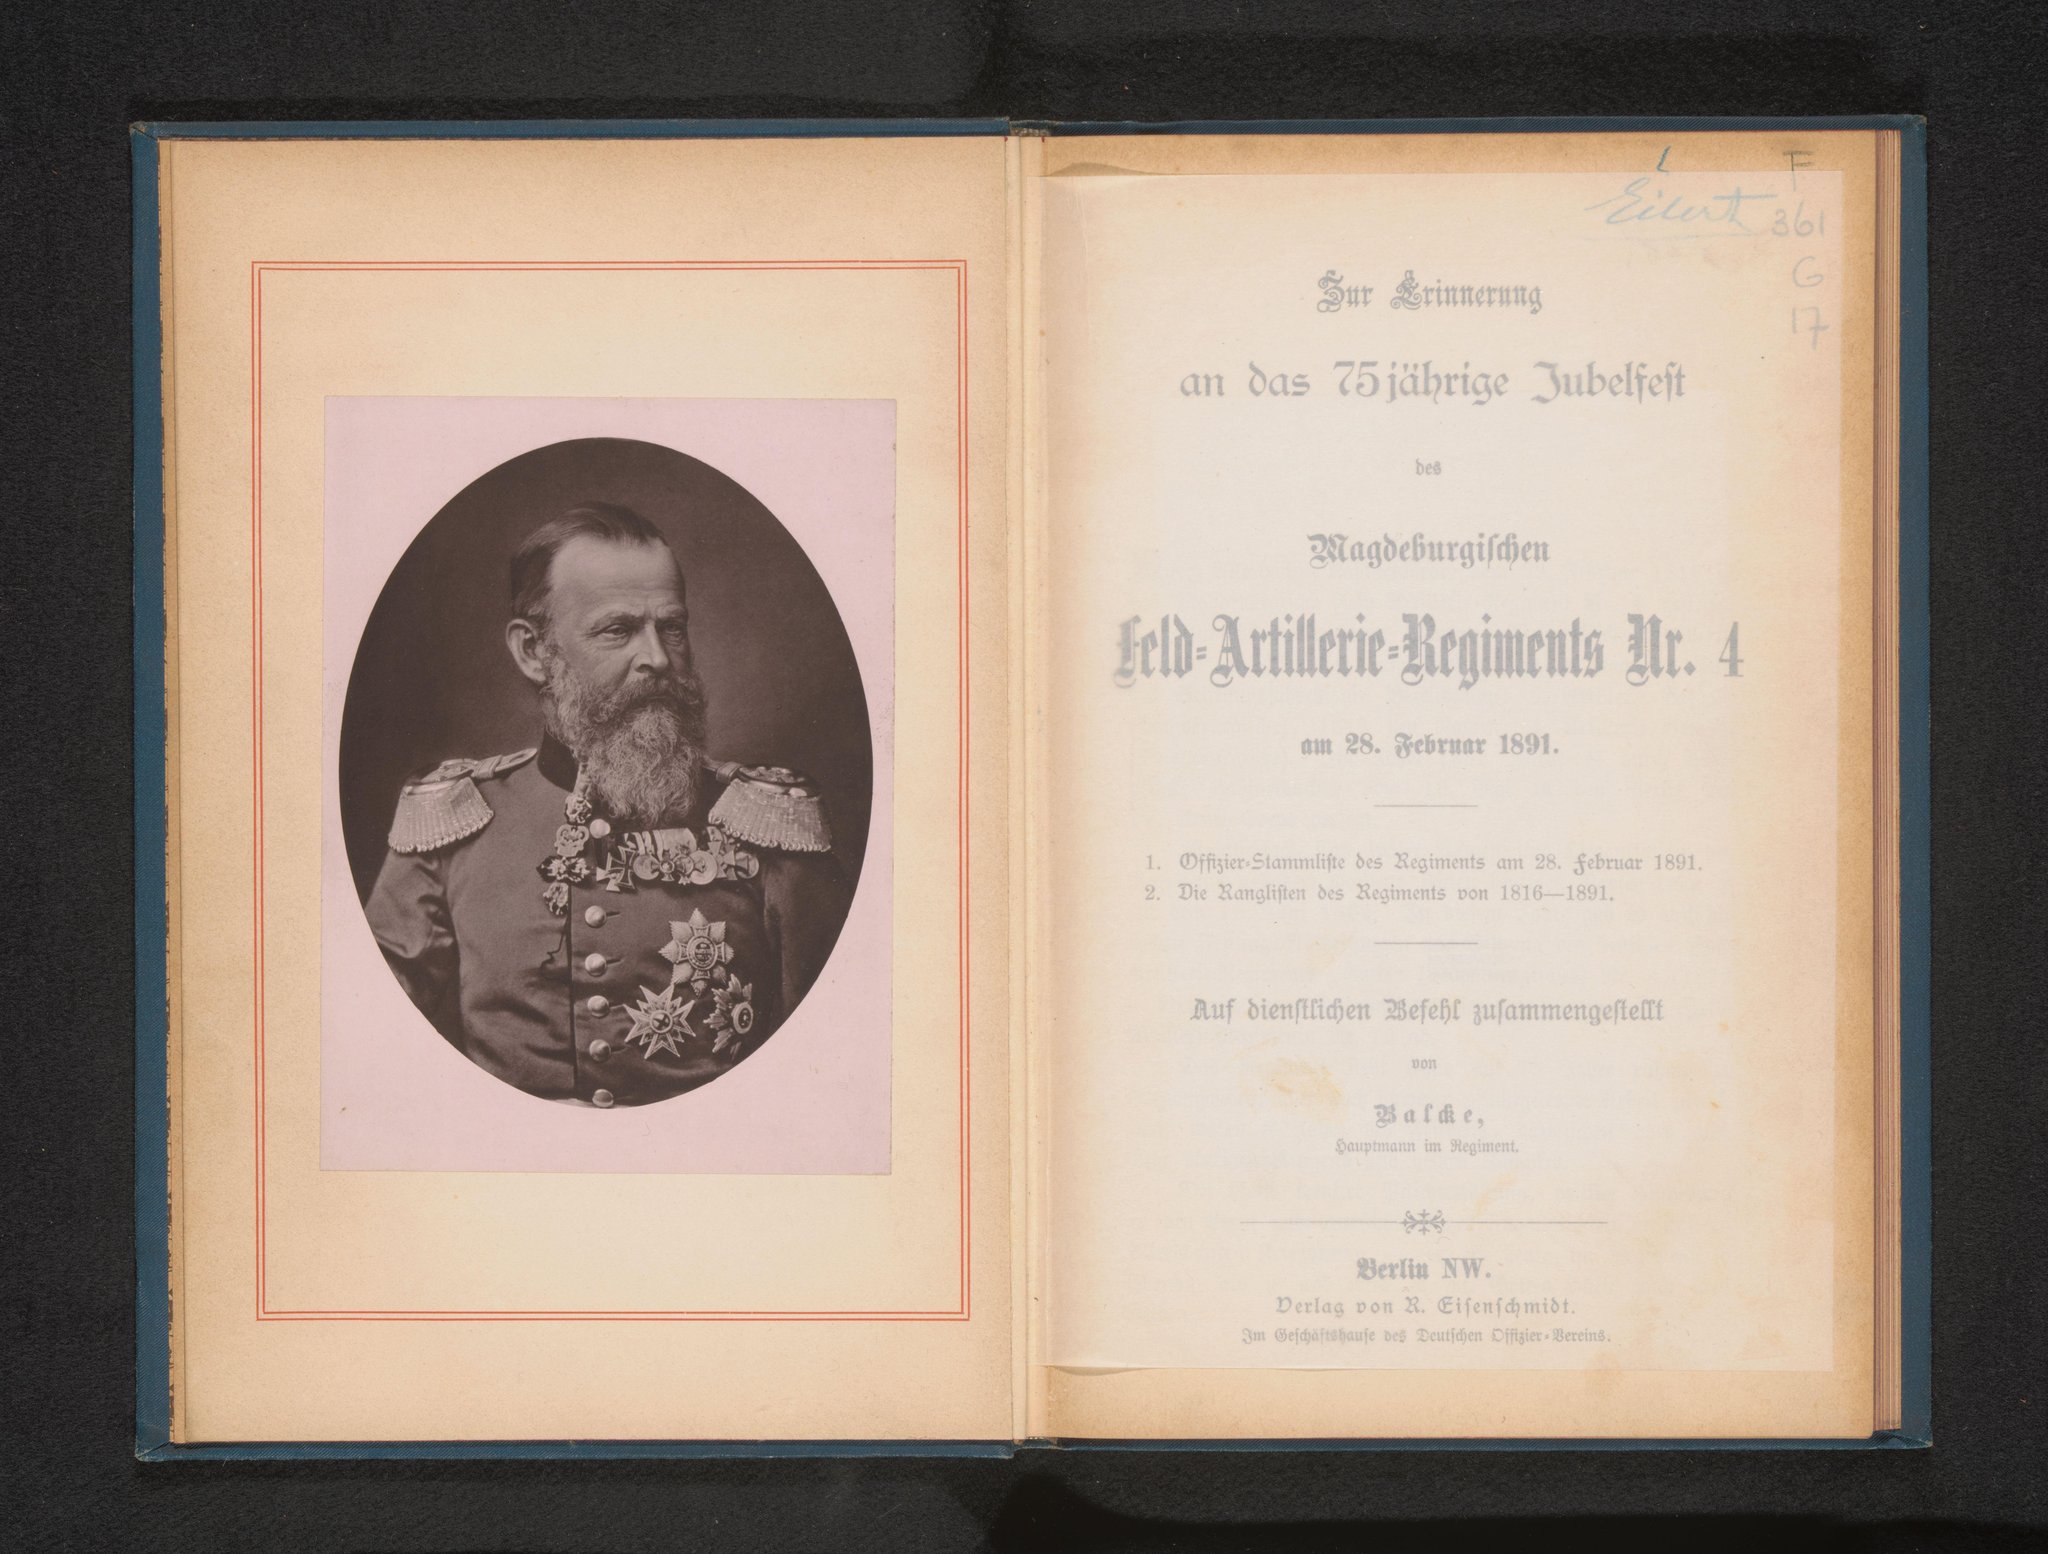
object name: page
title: Portret van Luitpold van Beieren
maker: Anonymous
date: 1886-1891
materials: paper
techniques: photograph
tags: historical persons